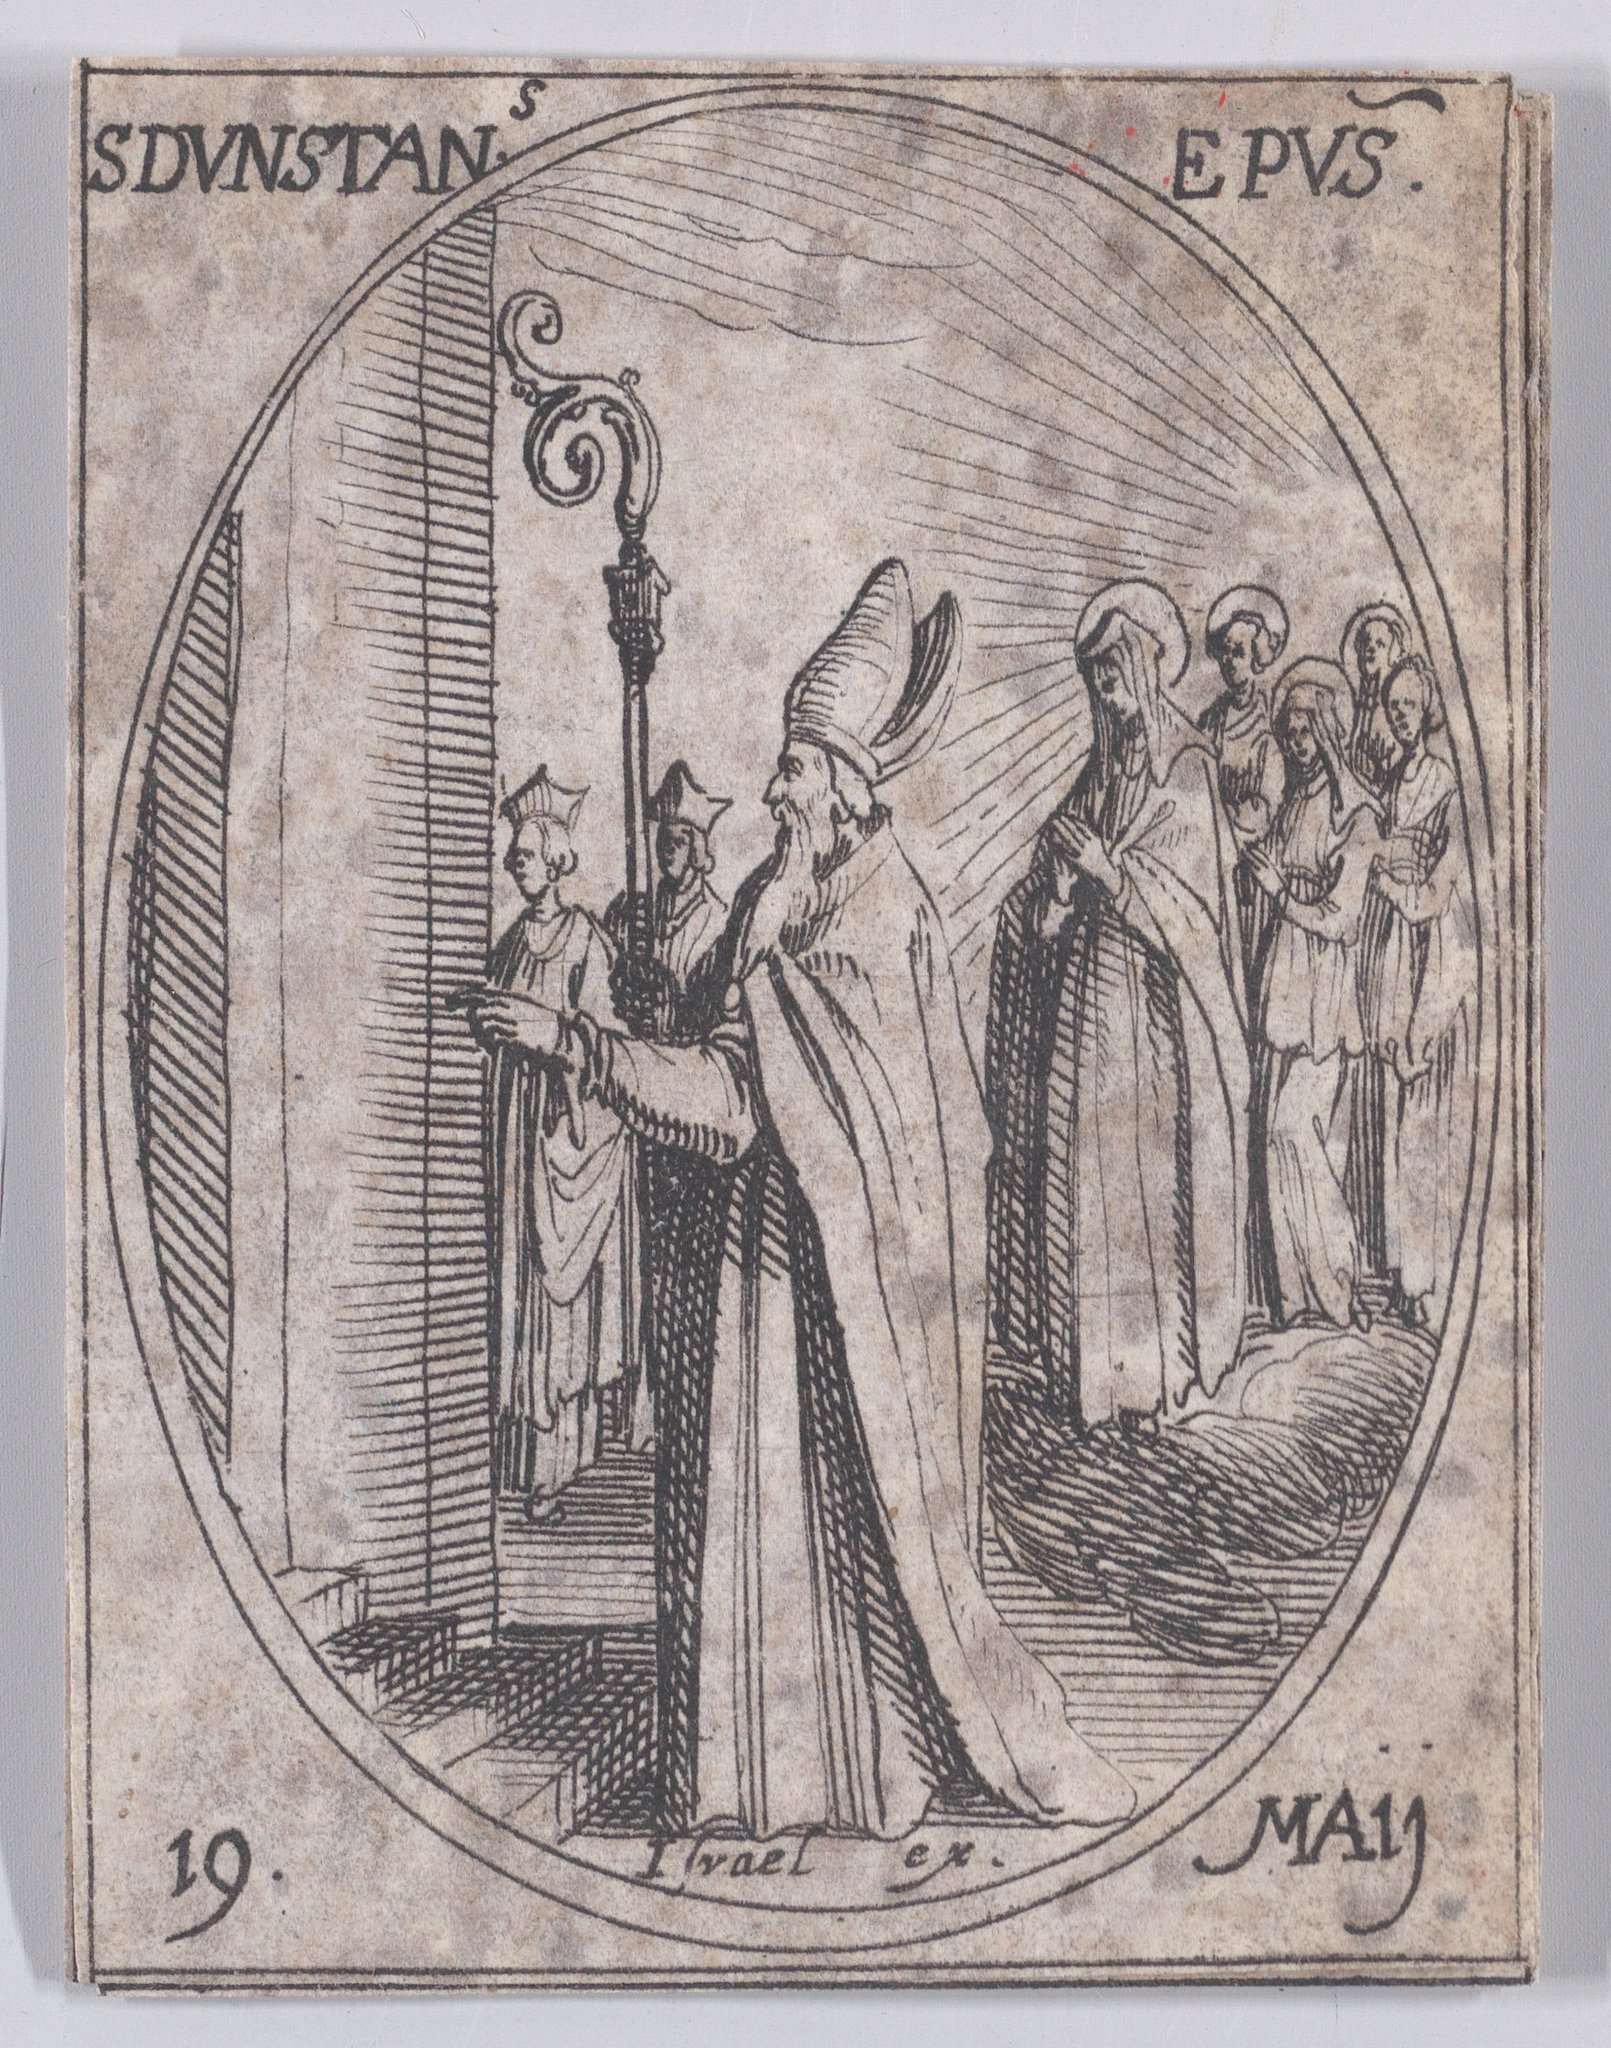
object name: print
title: S. Dunstan, évêque (St. Dunstan, Bishop), May 19th, from "Les Images De Tous Les Saincts et Saintes de L'Année" (Images of All of the Saints and Religious Events of the Year)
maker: jacques callot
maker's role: artist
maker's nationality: french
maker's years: 1592-1635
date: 1636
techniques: etching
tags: men,saints